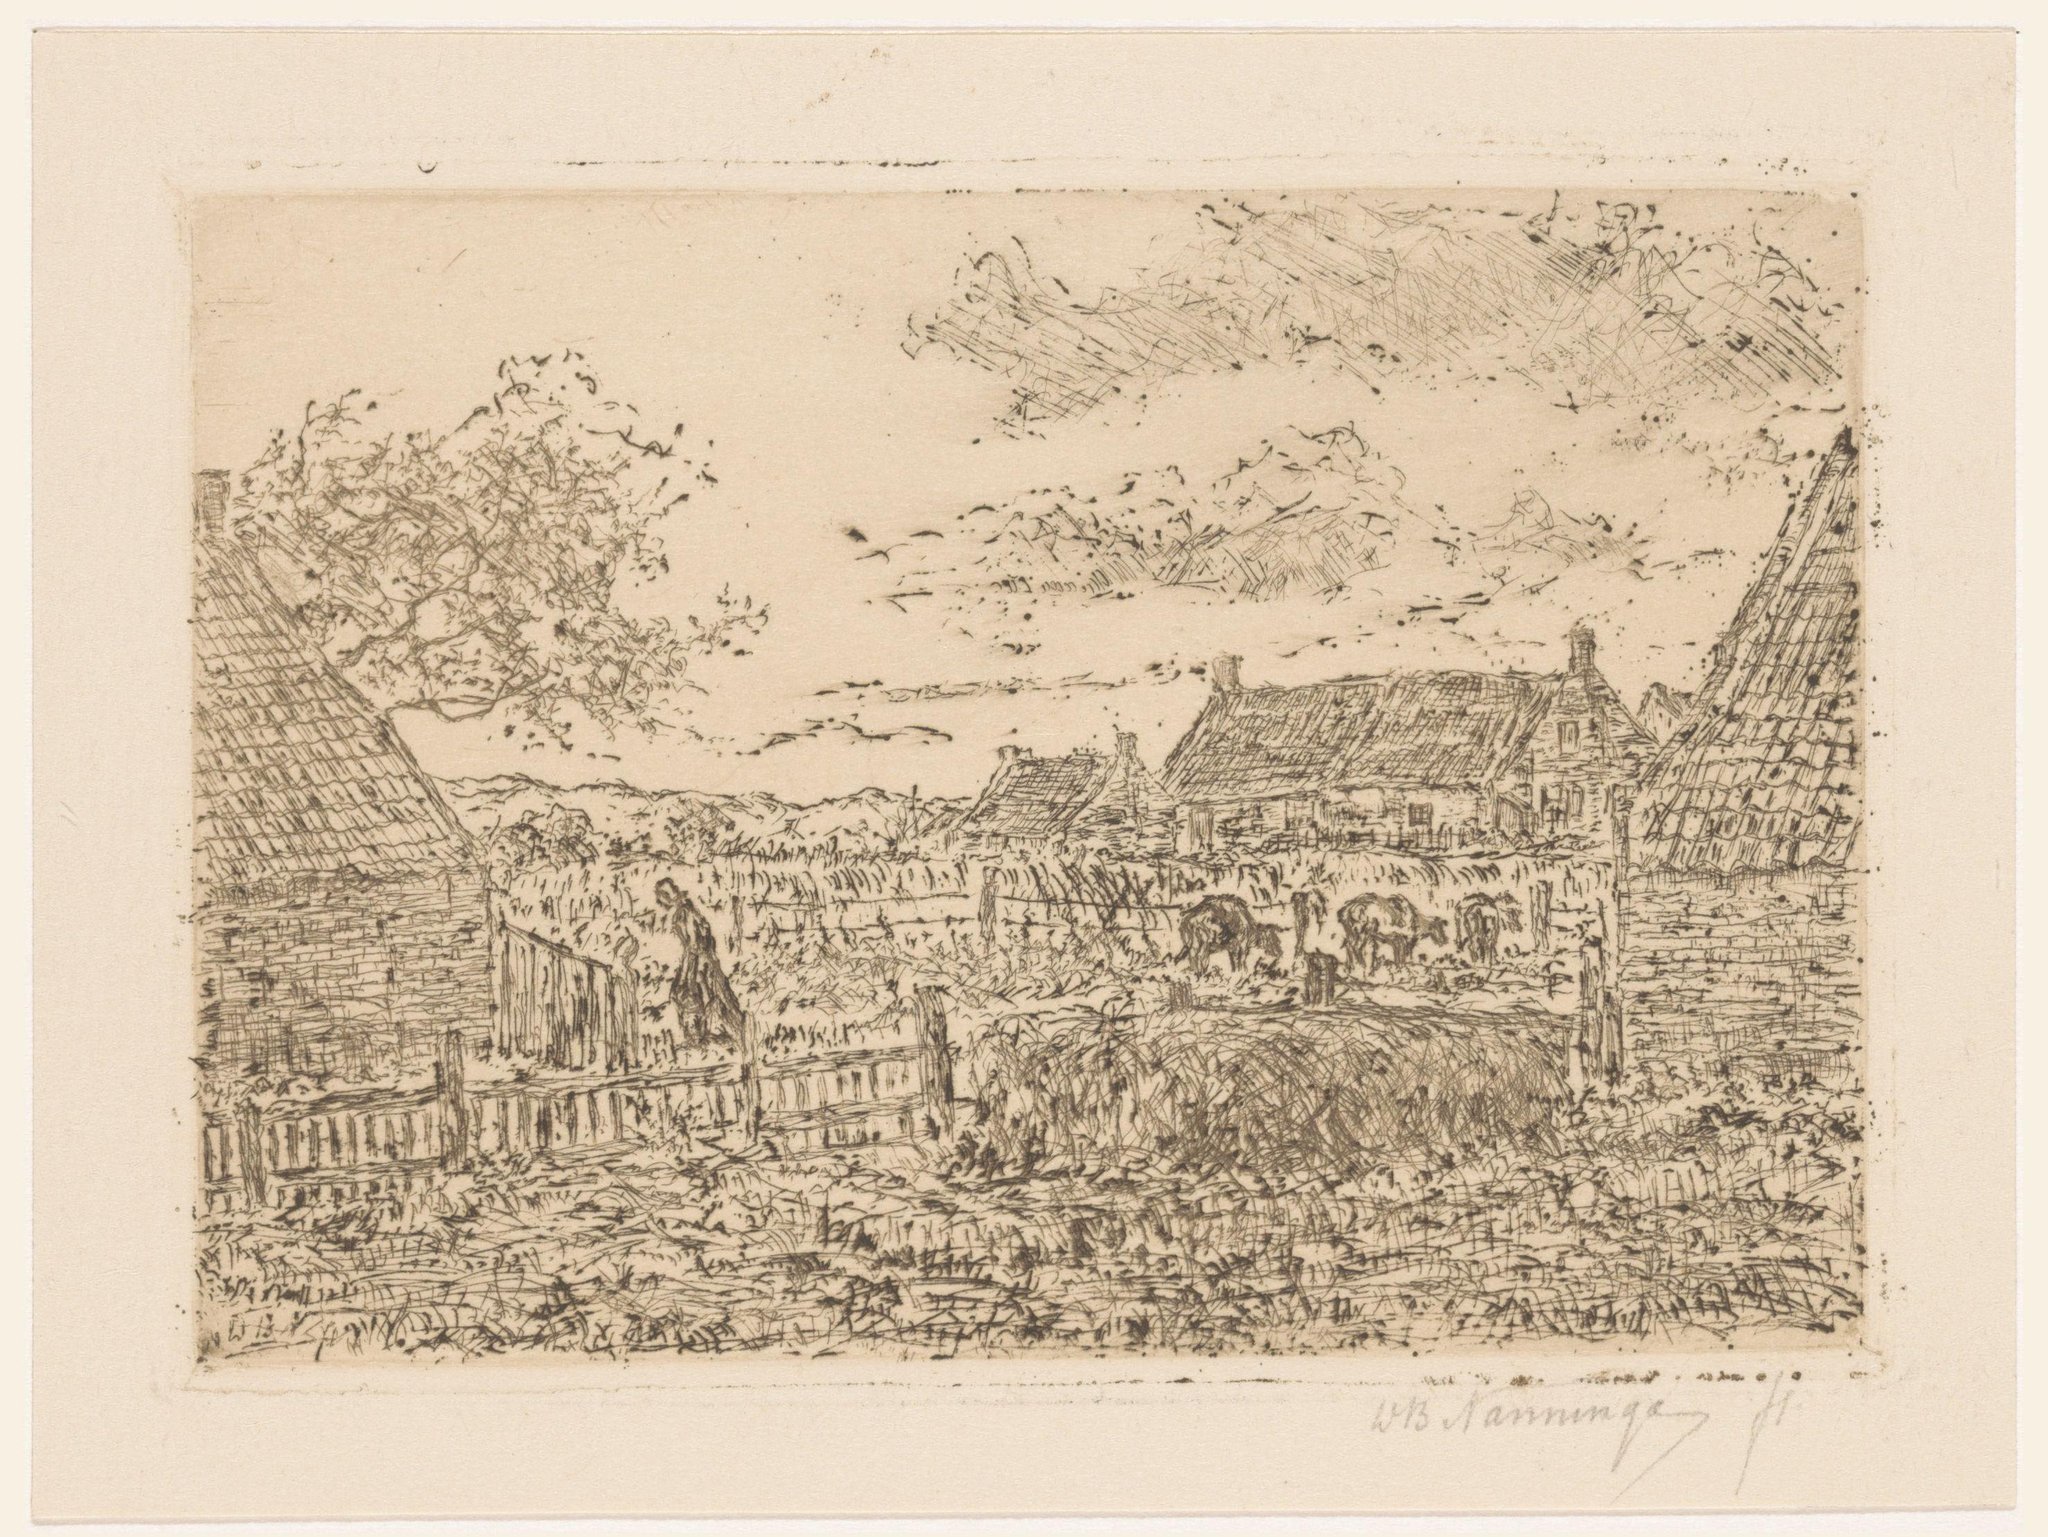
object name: print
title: Gezicht op boerenerf met runderen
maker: dirk berend nanninga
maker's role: print maker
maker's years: 1868-1954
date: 1878-1931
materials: paper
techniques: etching, intaglio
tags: bovine cattle, farm or solitary house in landscape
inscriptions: collector's mark: Lugt 2228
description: Links loopt een figuur naar een schuur toe.